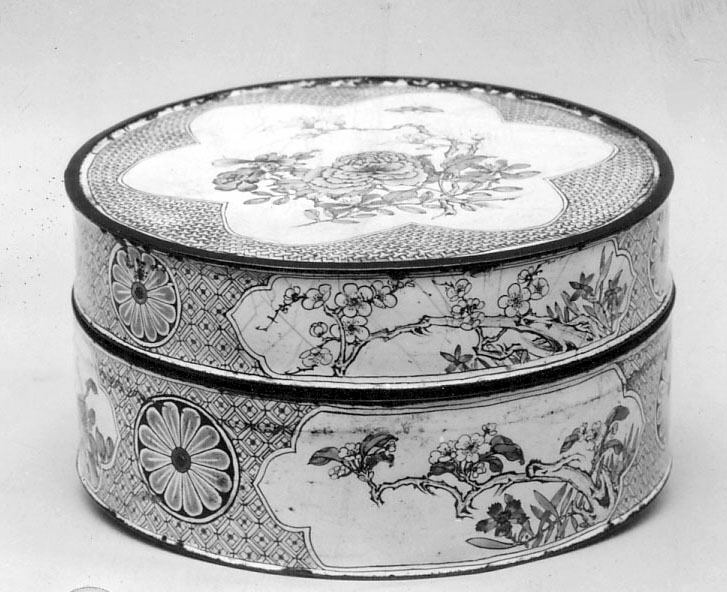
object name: covered box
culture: chinese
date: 1736-1795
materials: enamel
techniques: painting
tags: flowers,trees